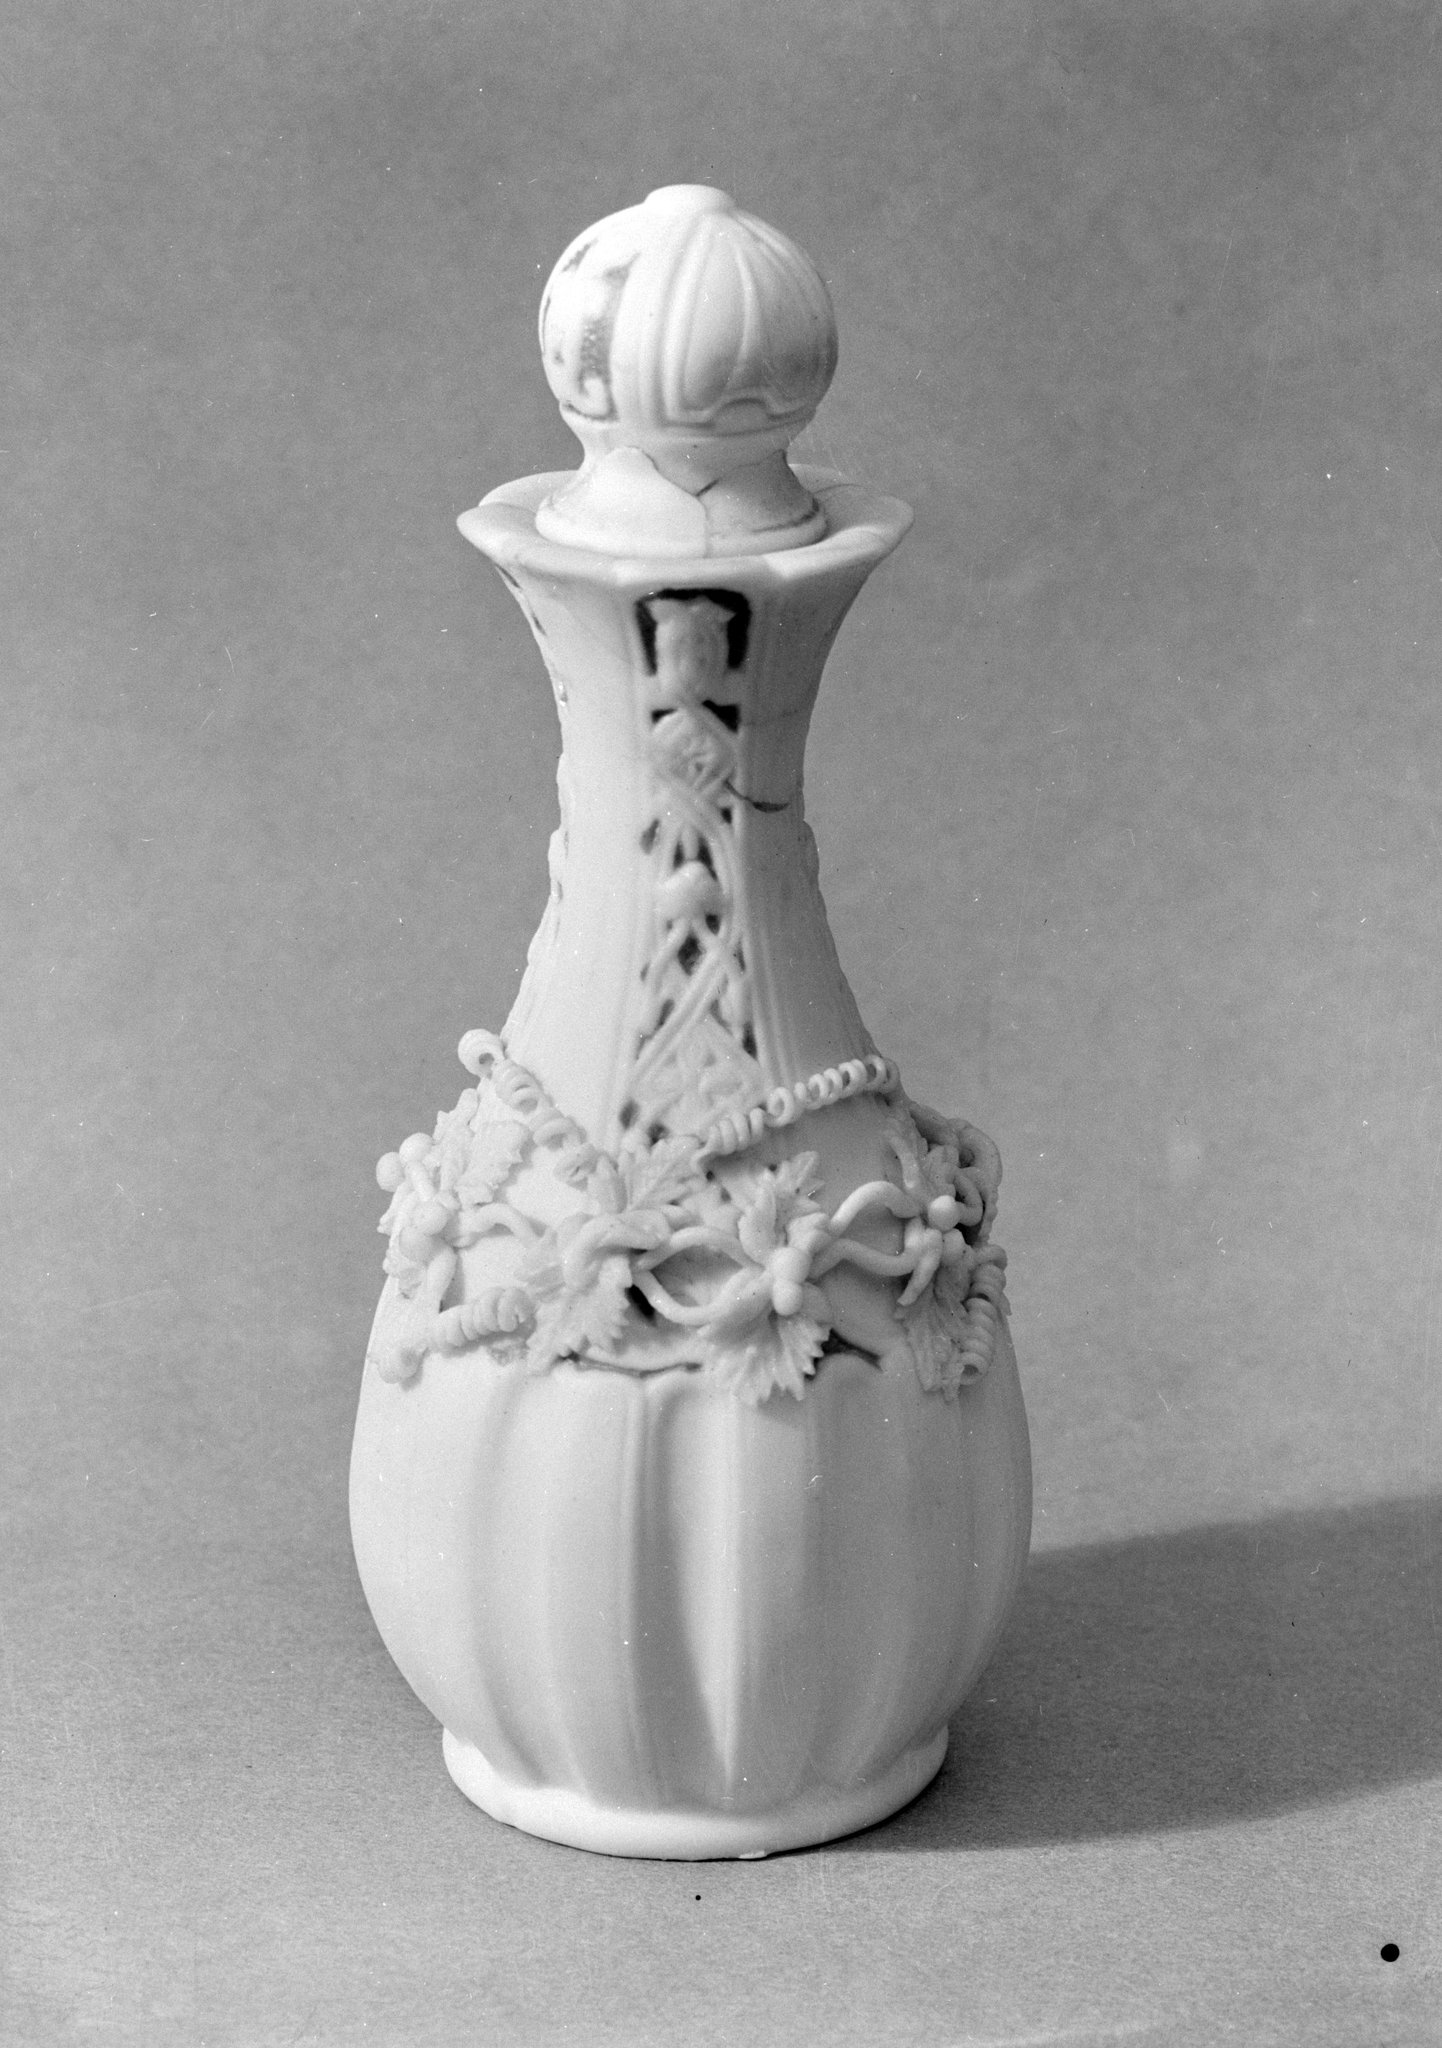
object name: perfume bottle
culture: american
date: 1830-1870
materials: porcelain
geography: united states